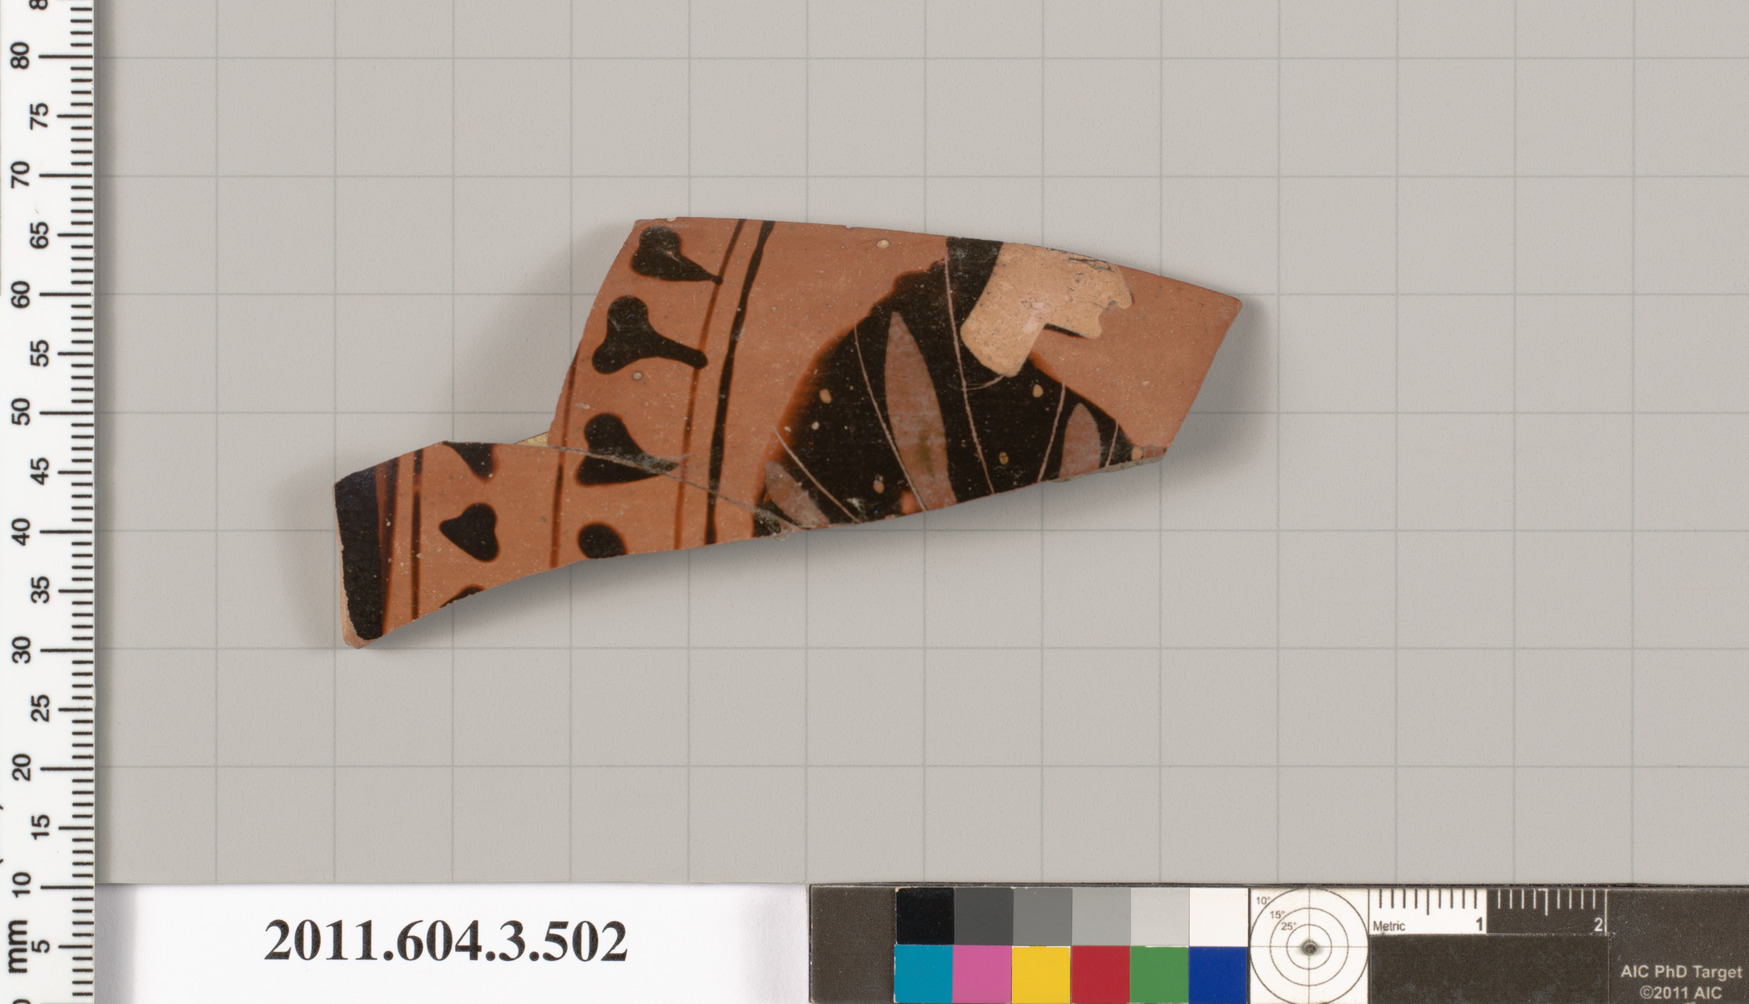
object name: column krater fragment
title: Terracotta fragment of a column-krater (bowl for mixing wine and water)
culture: greek, attic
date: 550-526 BCE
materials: terracotta